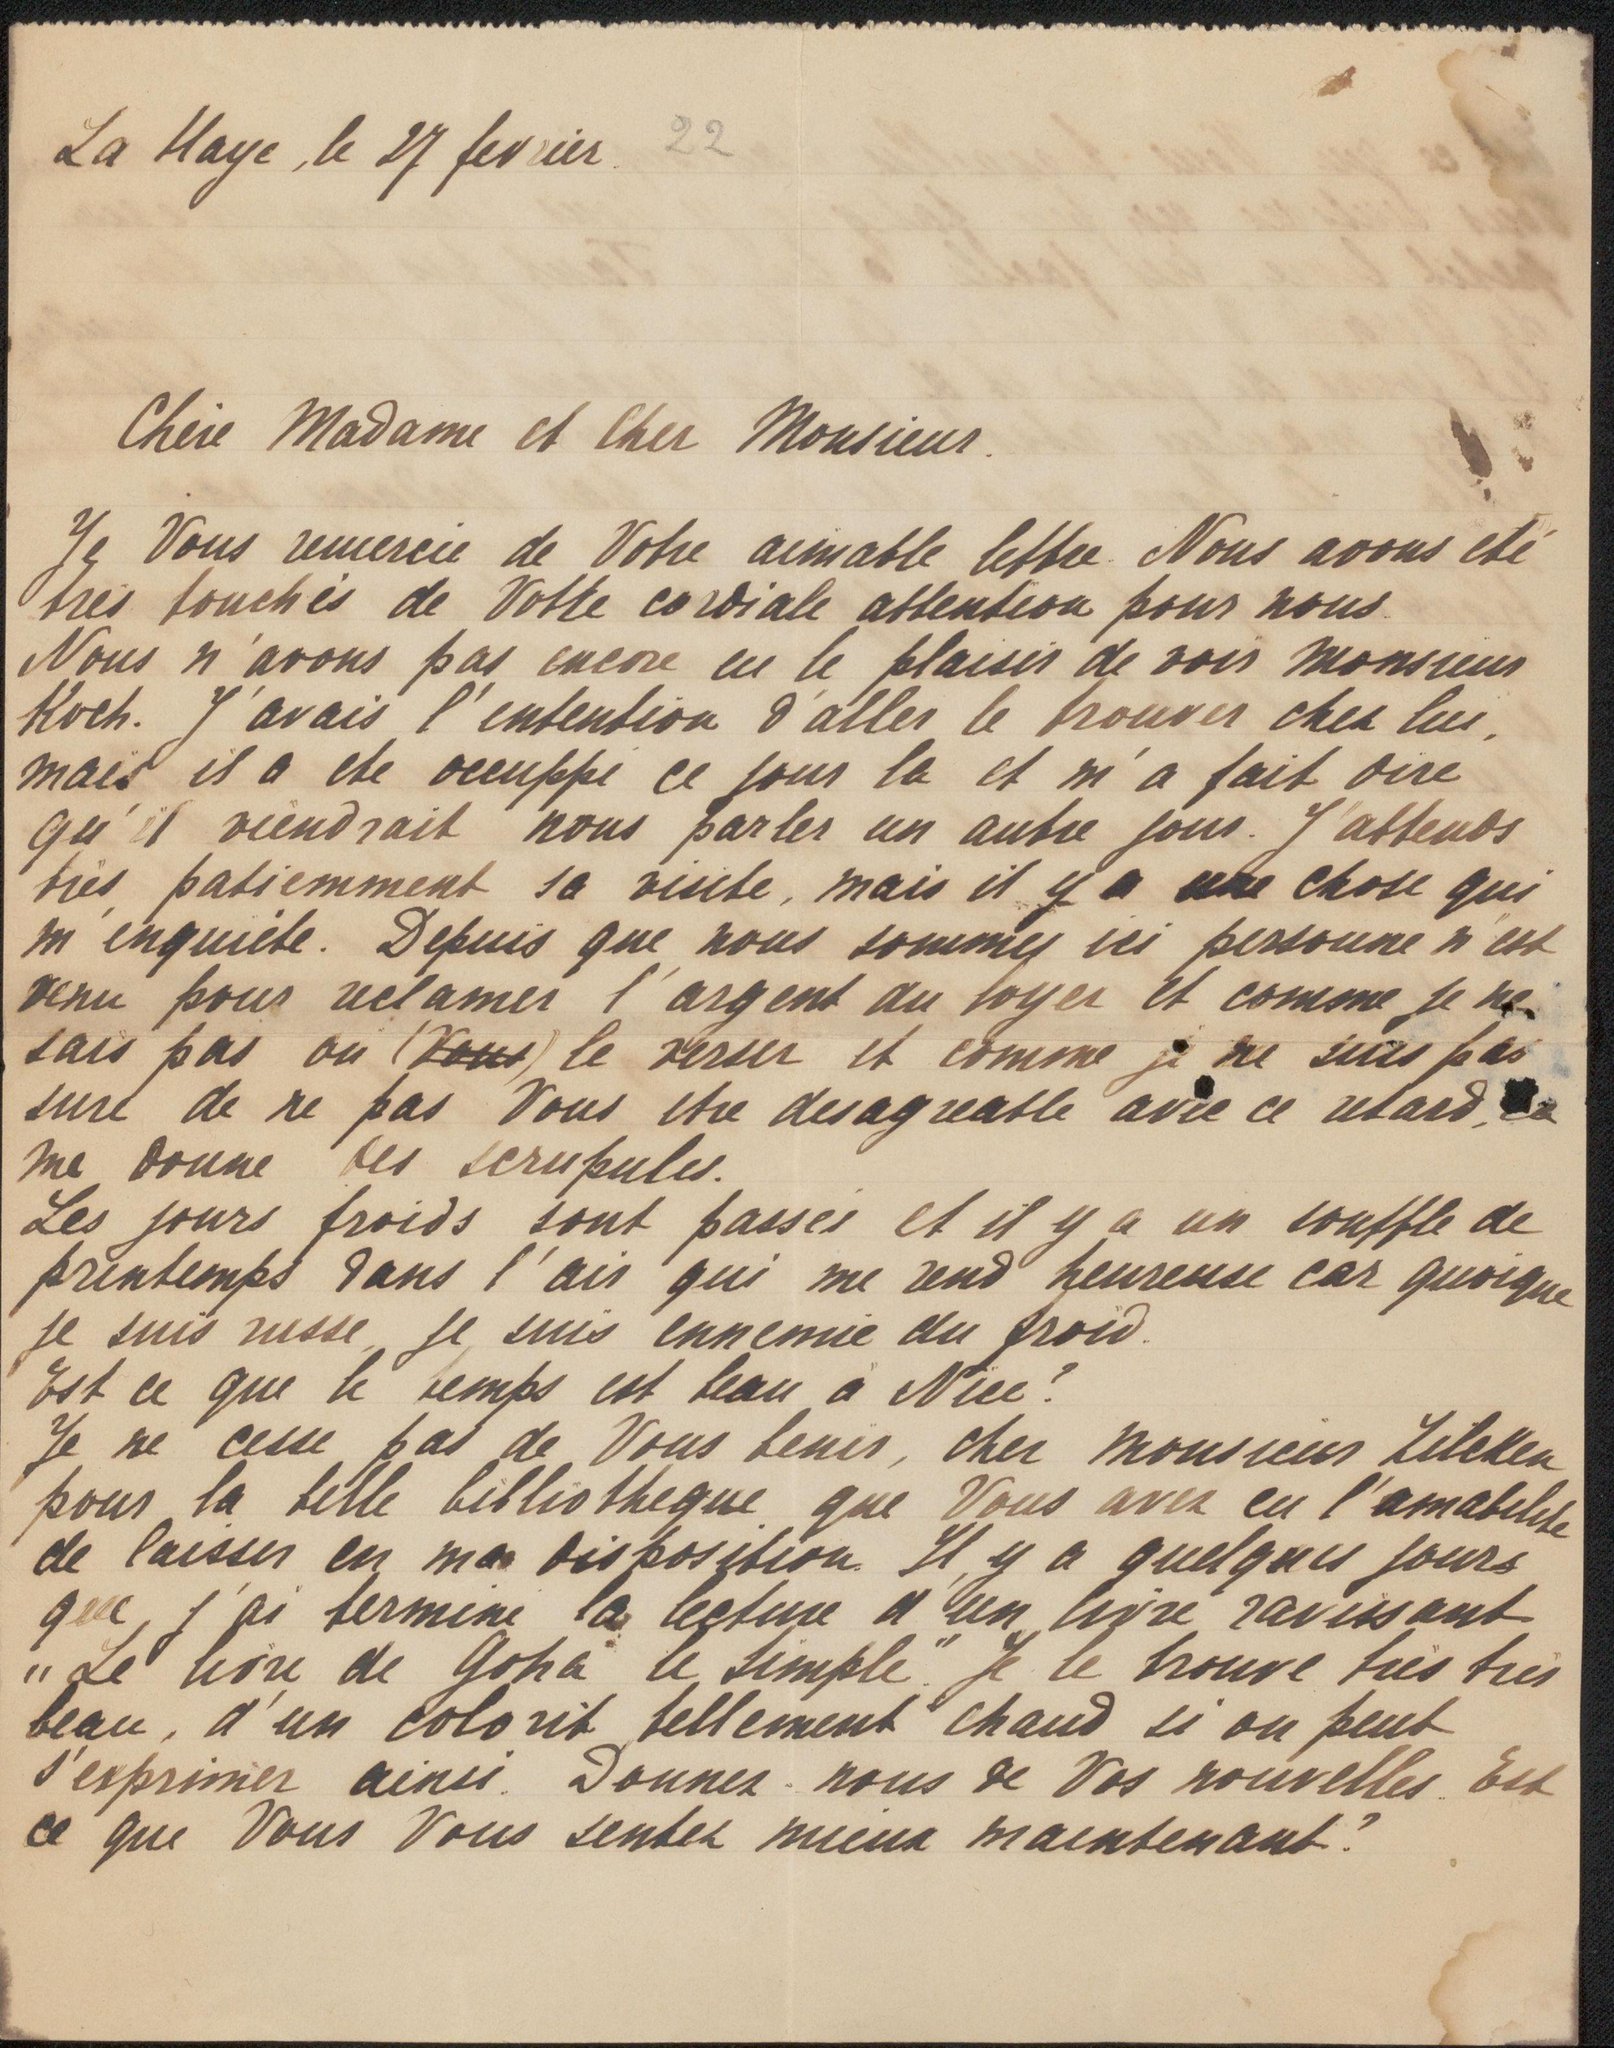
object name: letter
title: Brief aan Henriette Wilhelmina van Baak en Philip Zilcken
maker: anna sologoub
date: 1922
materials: ink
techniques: pen, writing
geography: the hague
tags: henriette wilhelmina van baak, the hague, painter, draughtsman, philip zilcken, literature ~ arts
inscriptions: collector's mark: ‘RPK’